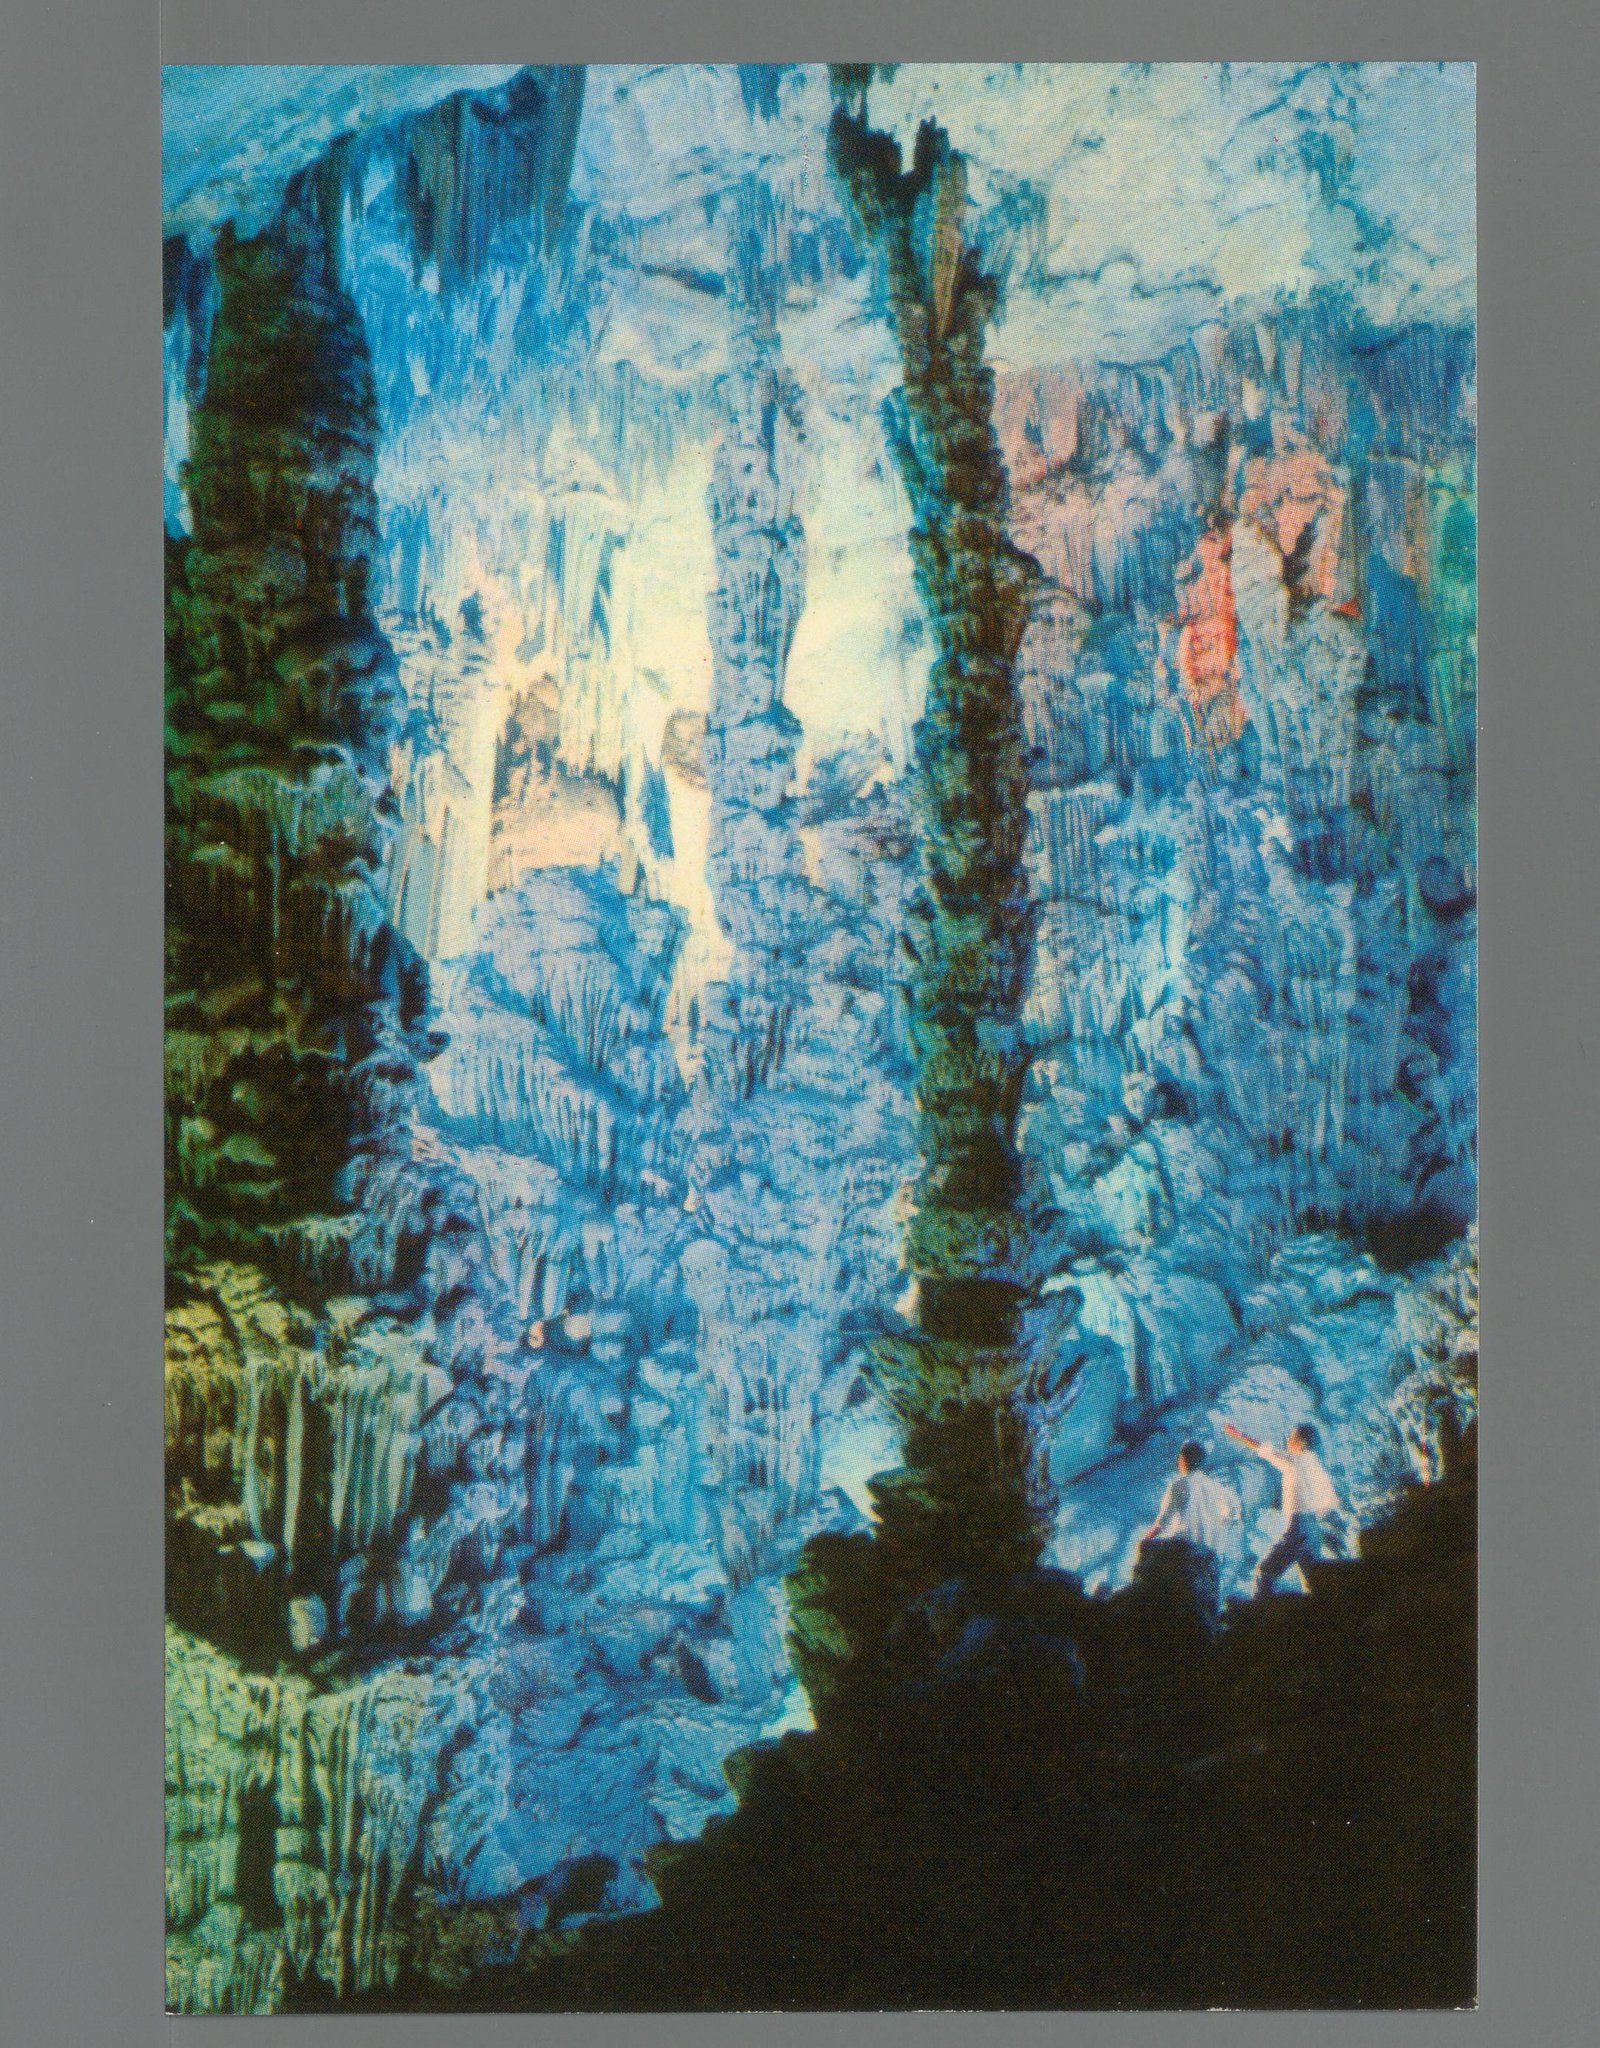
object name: ansichtkaart, prentbriefkaart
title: Dripstones in Reed Flute Cavern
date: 1974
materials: cardboard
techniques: offset printed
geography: beijing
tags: stalactitic cave